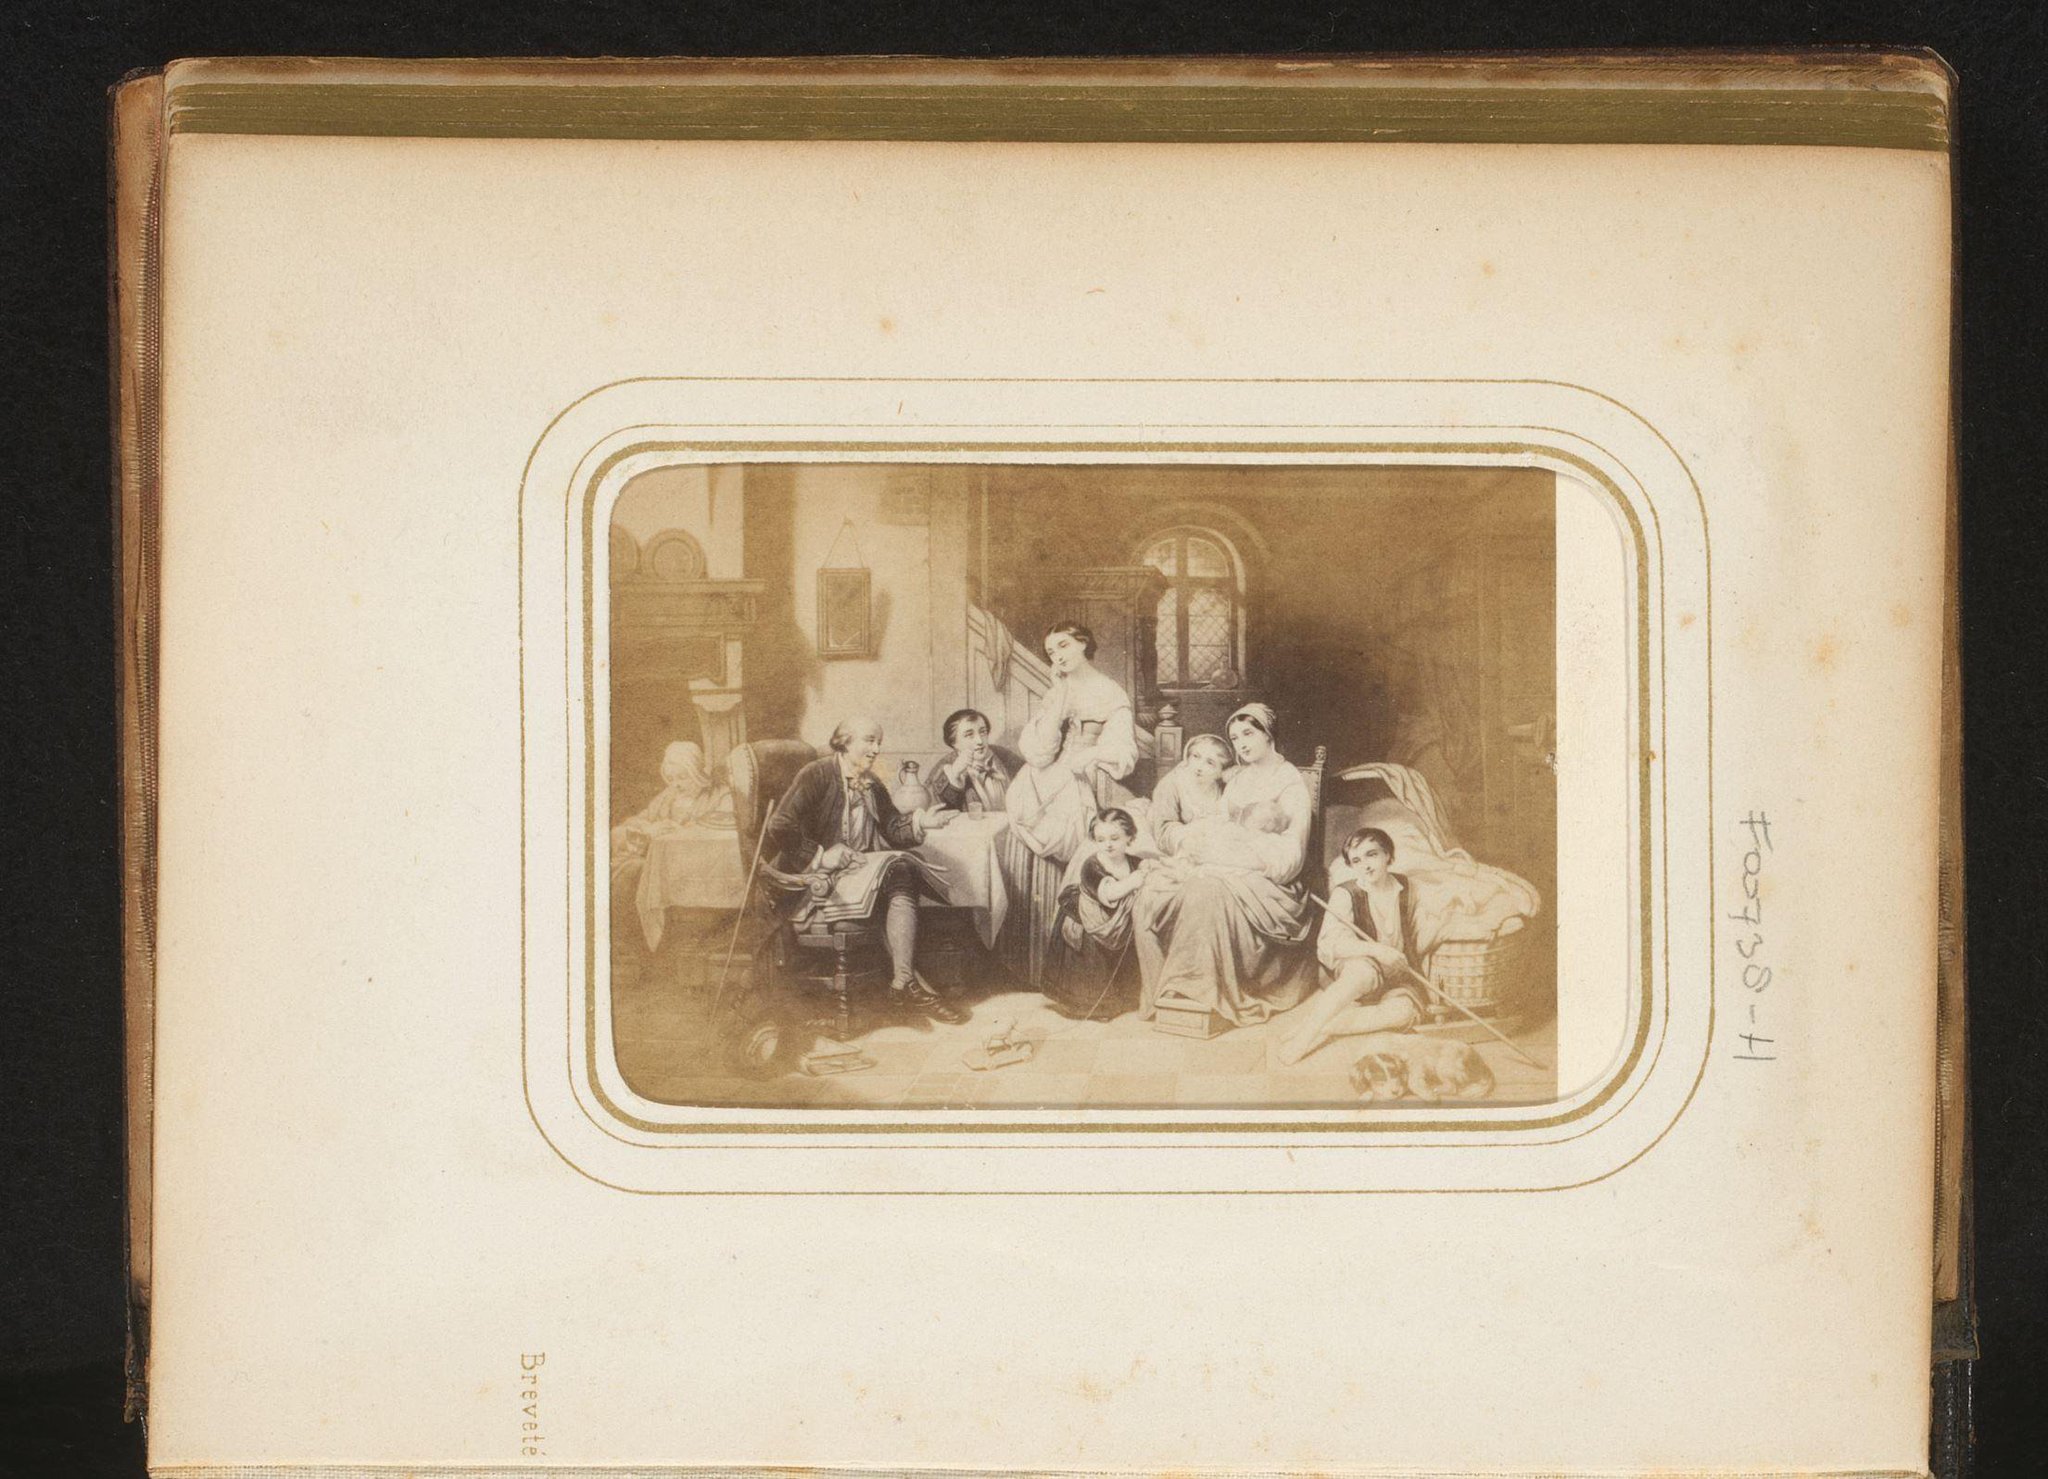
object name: reproduction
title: Fotoreproductie van een schilderij naar het gedicht Huisgodsdienst door J.J.L. ten Kate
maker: Anonymous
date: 1870-1890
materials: cardboard, photographic support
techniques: albumen print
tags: reading the bible or other religious books, family life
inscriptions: inscription: ‘HUISGODSDIENST./ Als (...) stem gehoord!/ J. J. L. TEN KATE.’, inscription: ‘Breveté S.G.D.G.’